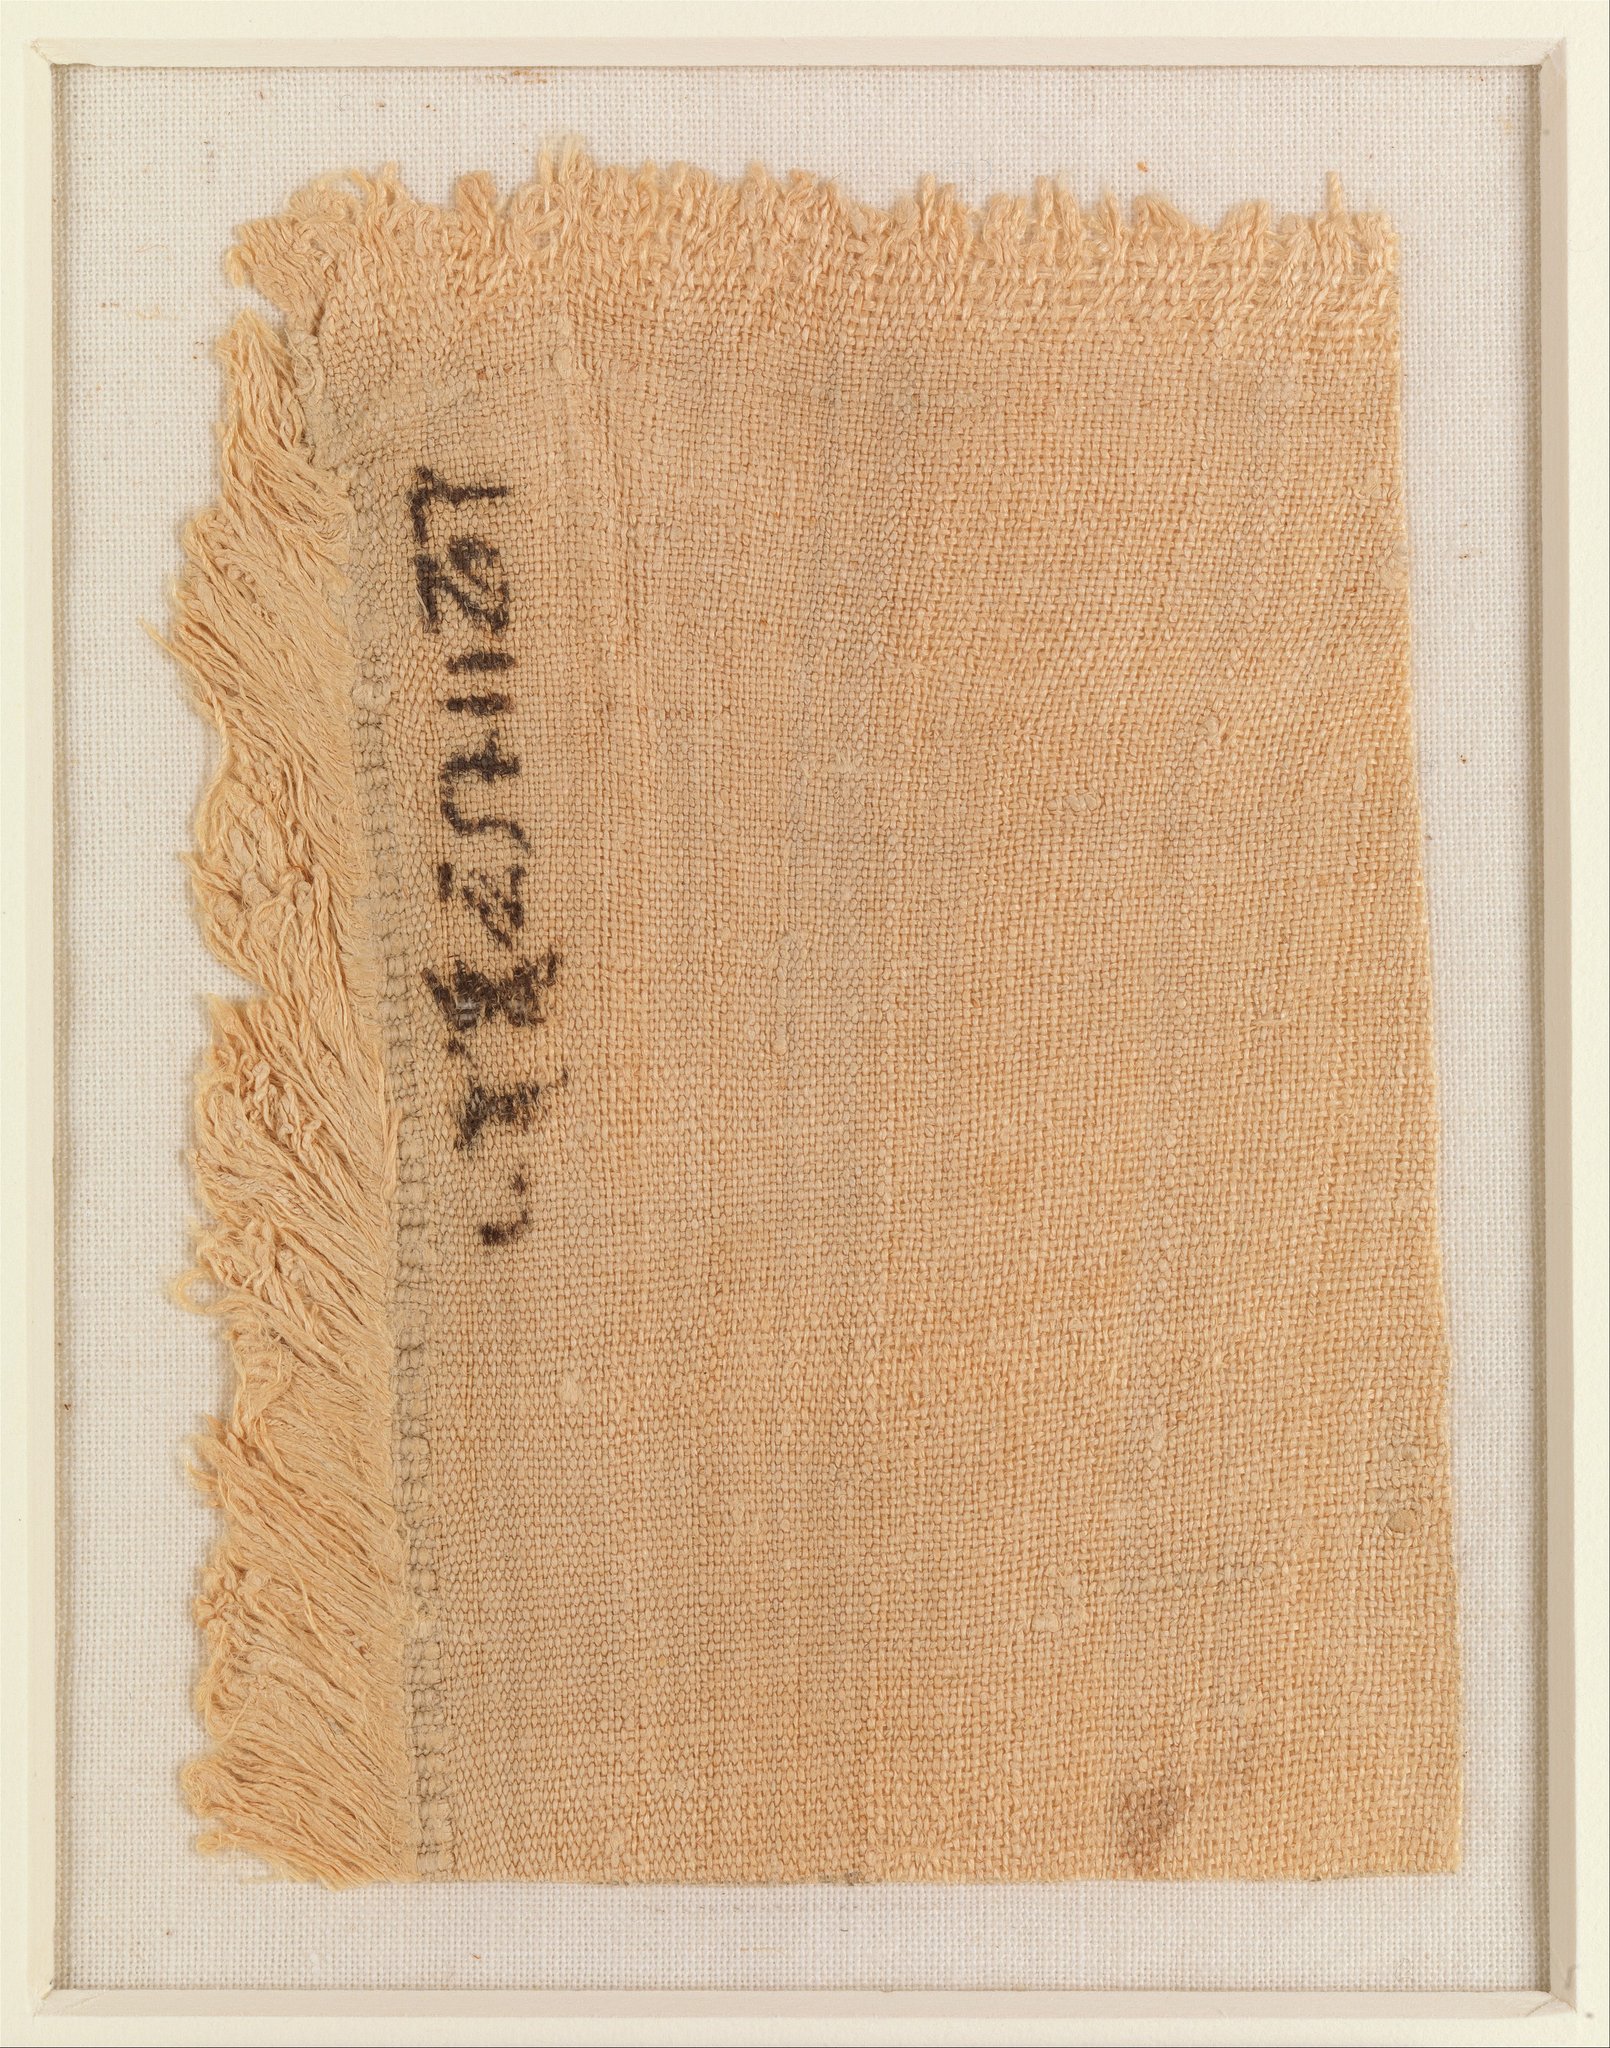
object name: linen mark, wah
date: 1981-1975 BCE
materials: linen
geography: egypt